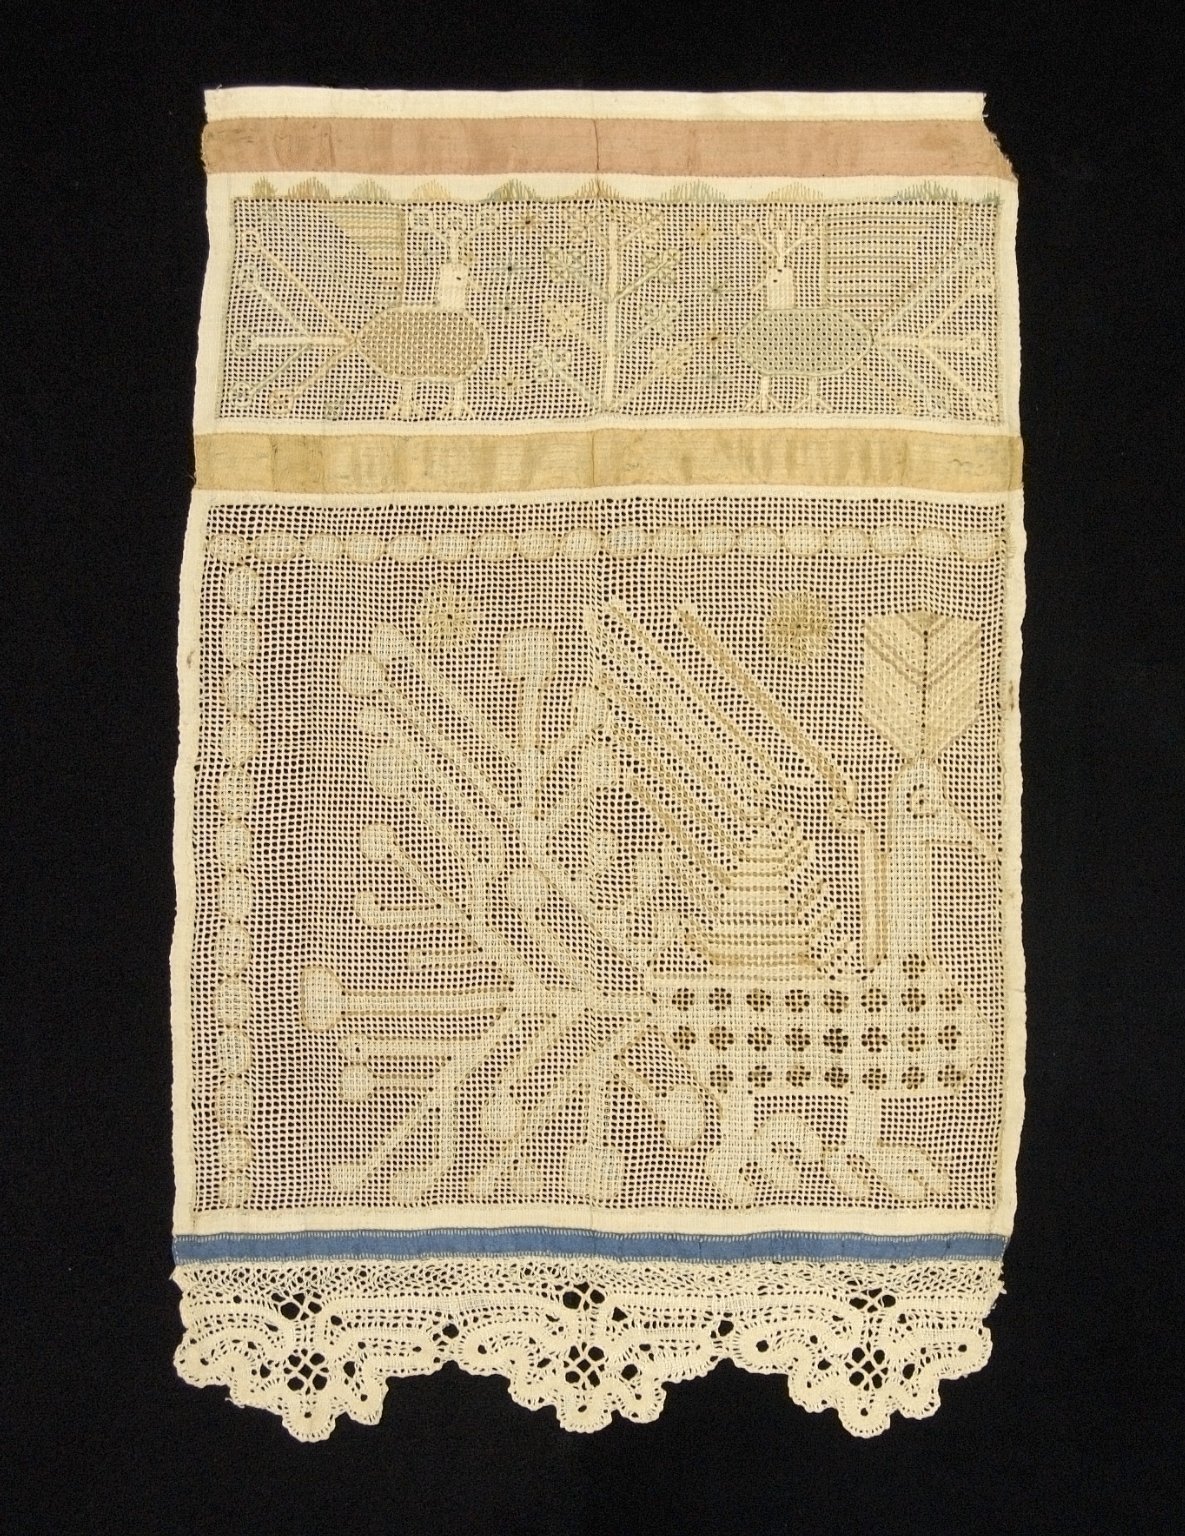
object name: border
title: Towel border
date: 1800-1850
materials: linen, silk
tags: birds